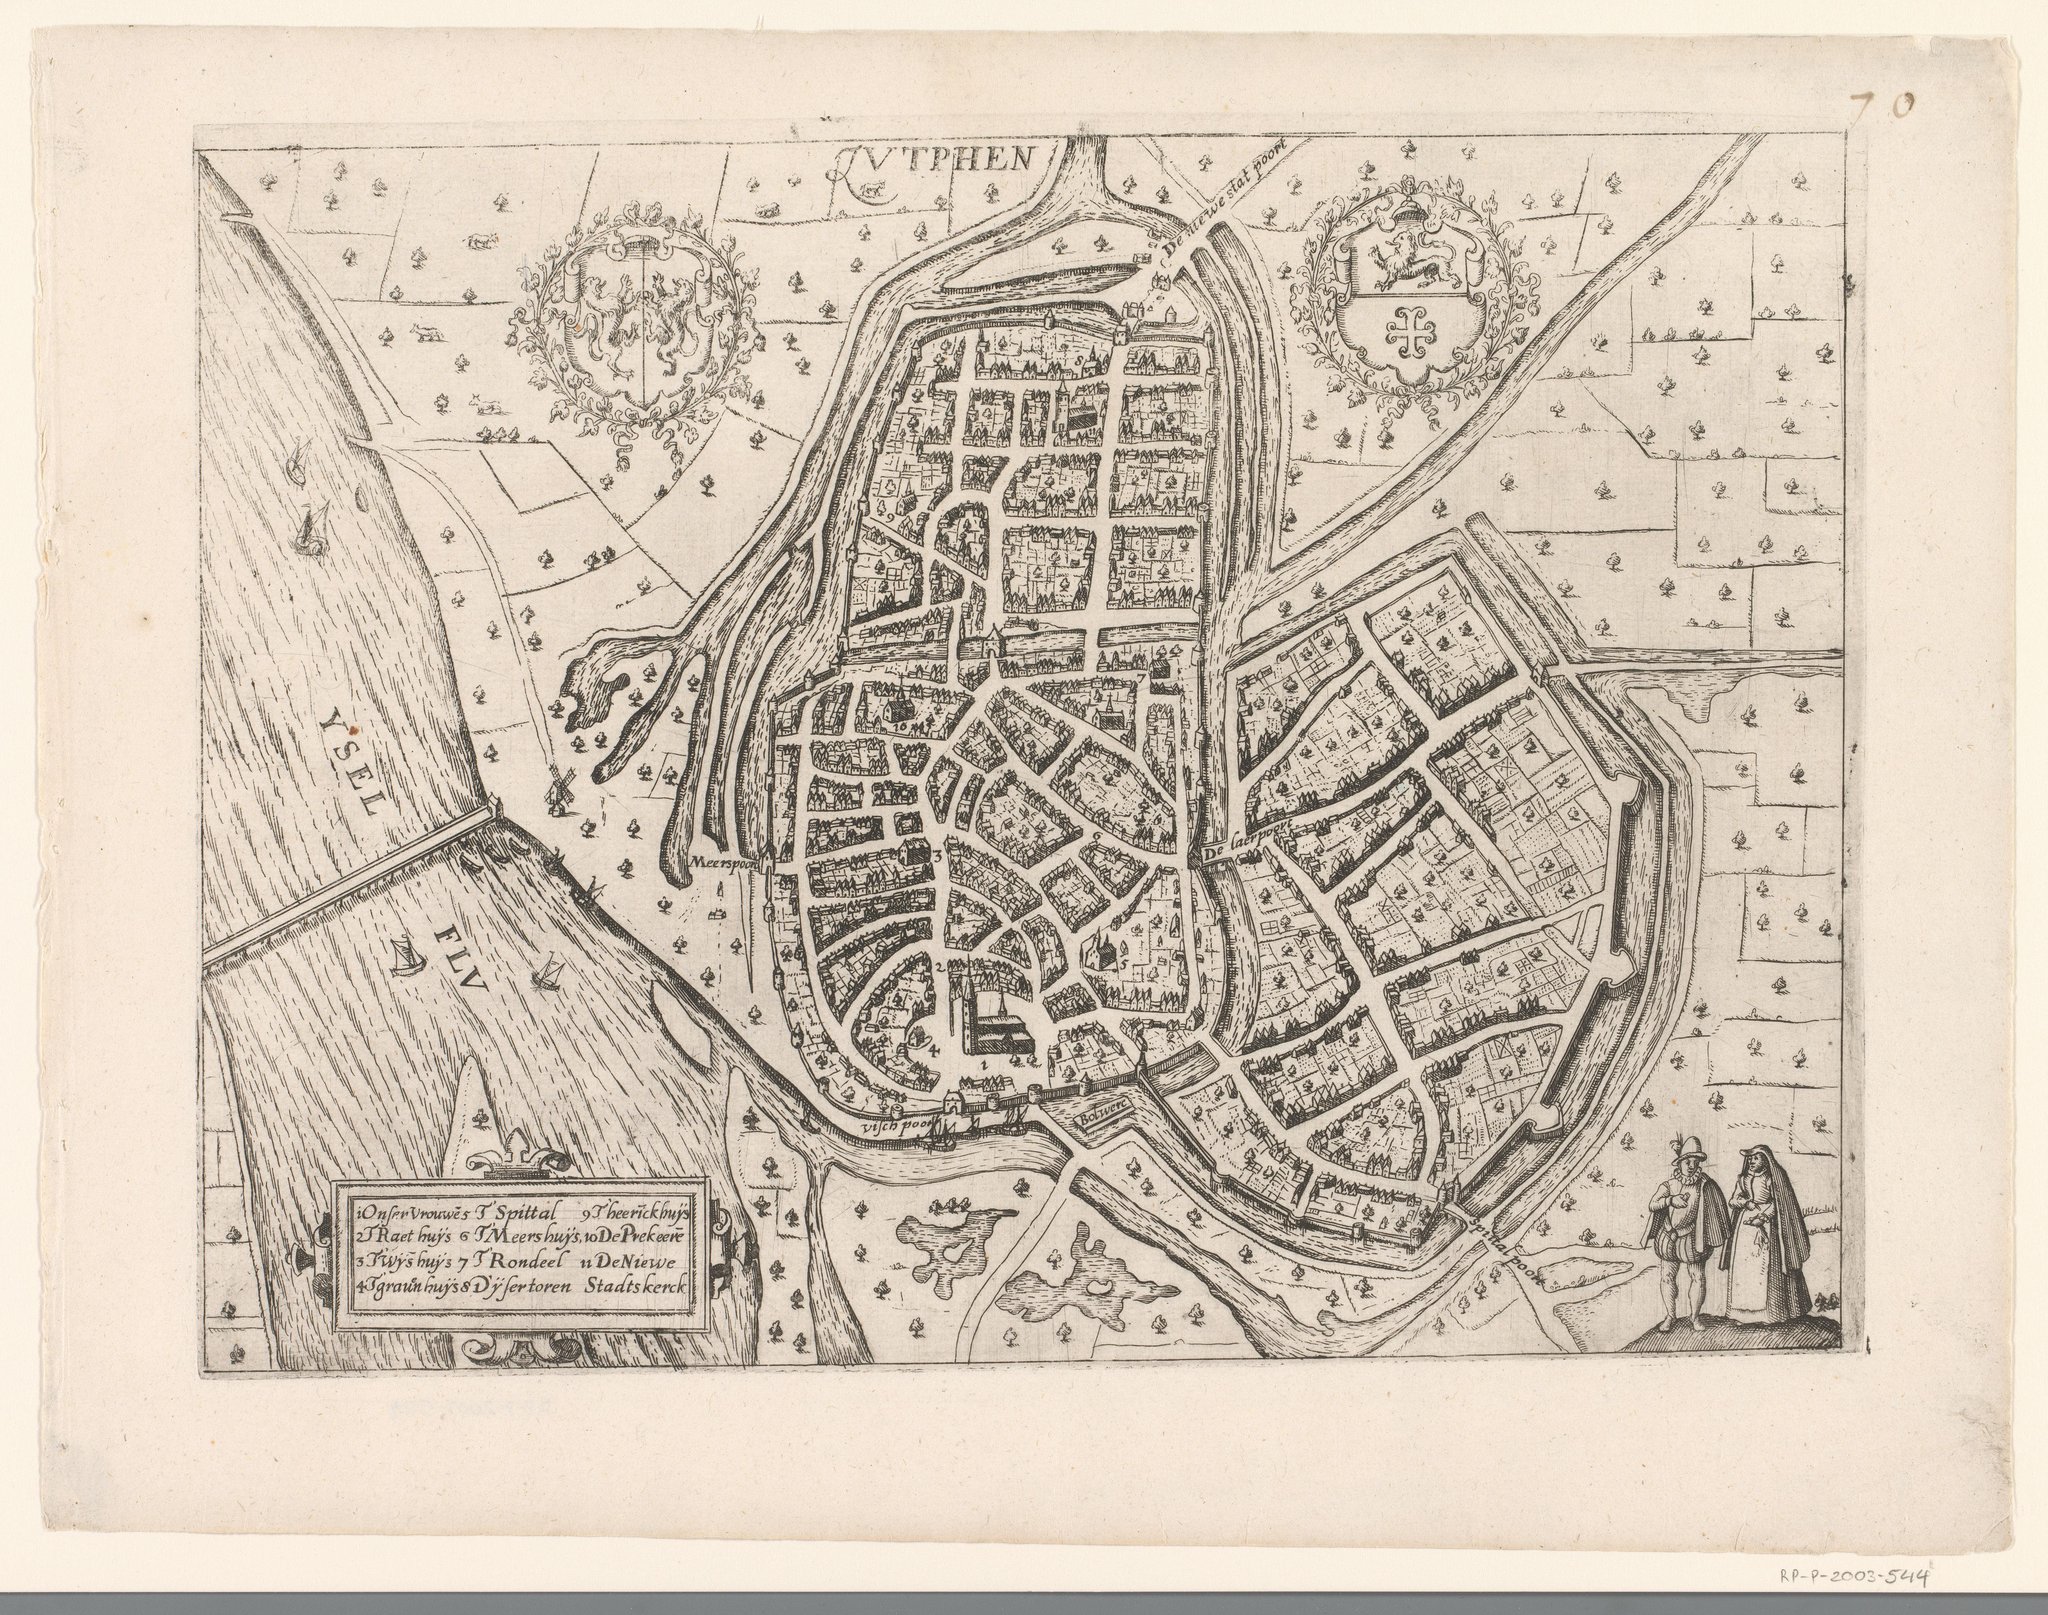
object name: area plan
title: Zutphen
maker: Anonymous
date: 1607-1609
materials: paper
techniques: etching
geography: southern netherlands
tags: maps of cities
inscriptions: number: ‘70’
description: Plattegrond van de stad Zutphen. Midden boven de titel, linksboven het wapen van de unie van het hertogdom Gelre en de graafschap Zutphen, rechtsboven het stadswapen. Linksonder een cartouche met de legenda 1-11. Rechtsonder een man en een vrouw. Onderdeel van de verzameling kaarten genomen uit een latere editie van: Descrittione di tutti i Paesi Bassi van Lodovico Guicciardini.